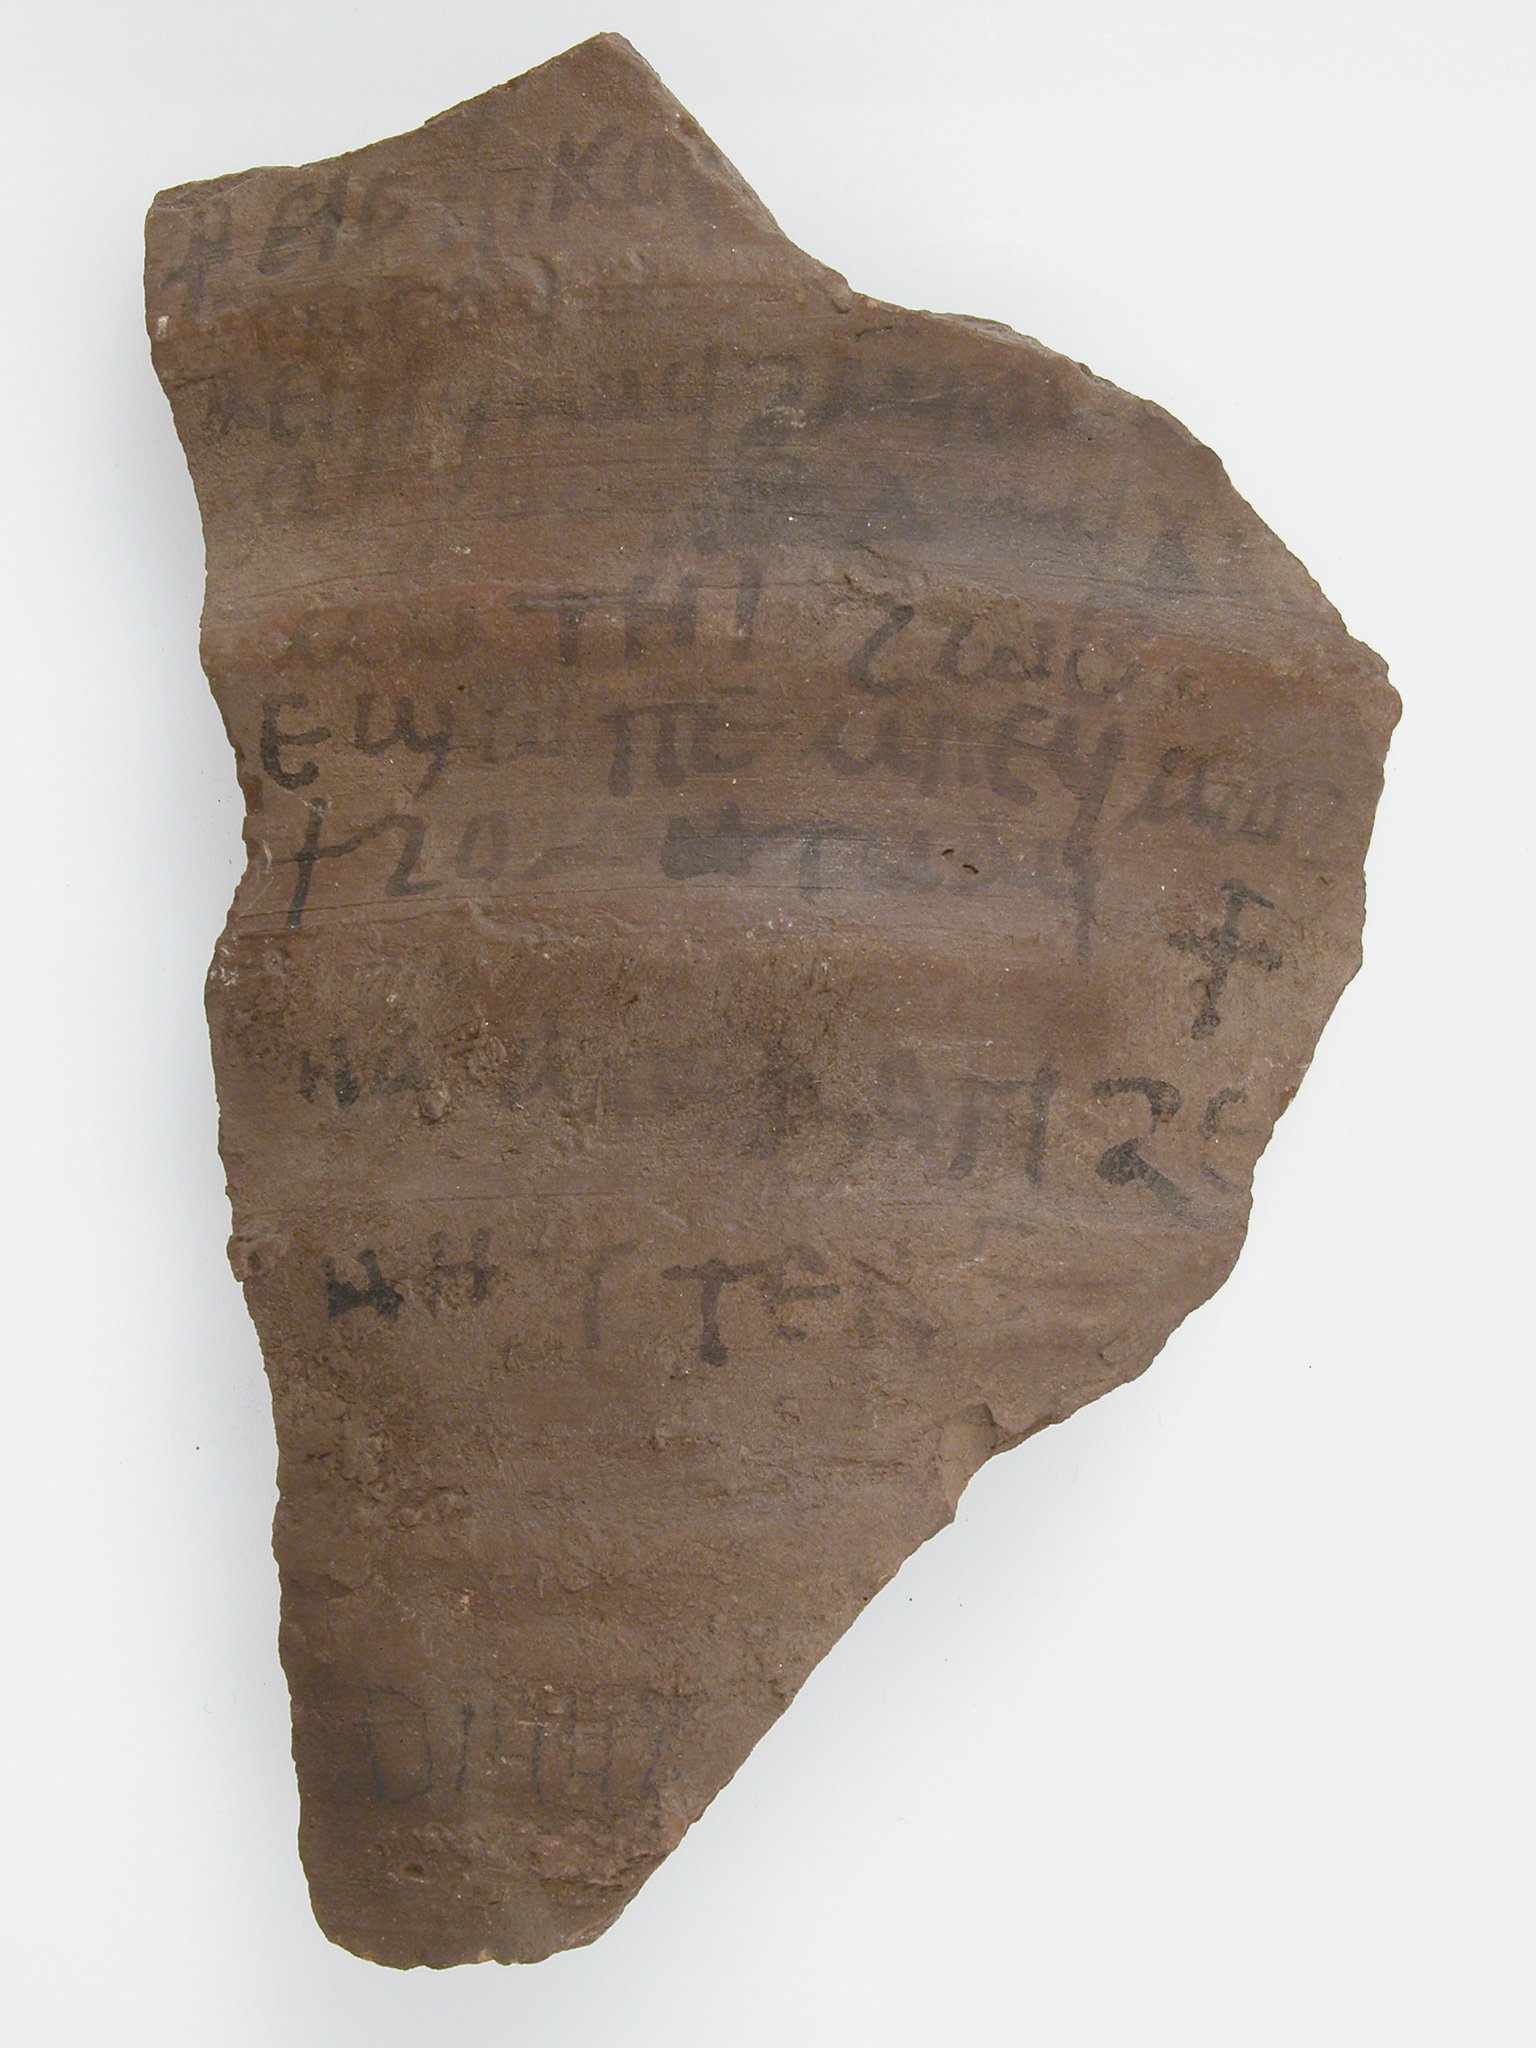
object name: ostrakon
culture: coptic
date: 601-700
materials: ink, pottery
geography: egypt